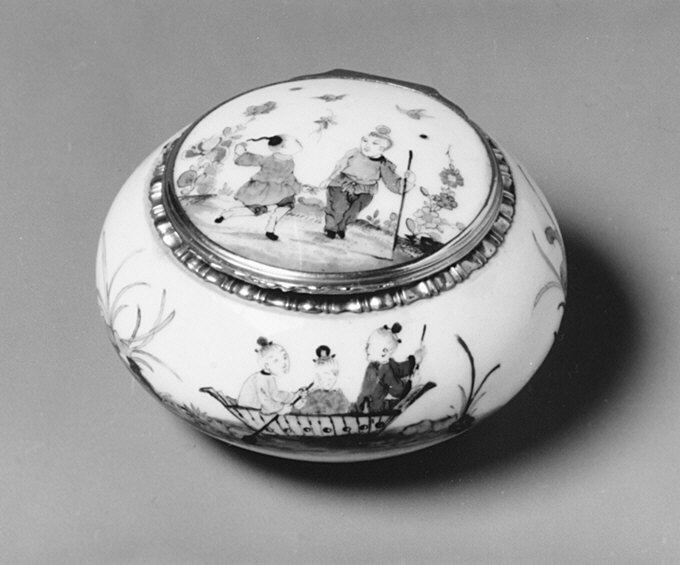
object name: snuffbox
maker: meissen manufactory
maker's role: manufactory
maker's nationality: german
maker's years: 1710-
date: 1730-1735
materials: gold, hard paste porcelain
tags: birds,men,women,boats